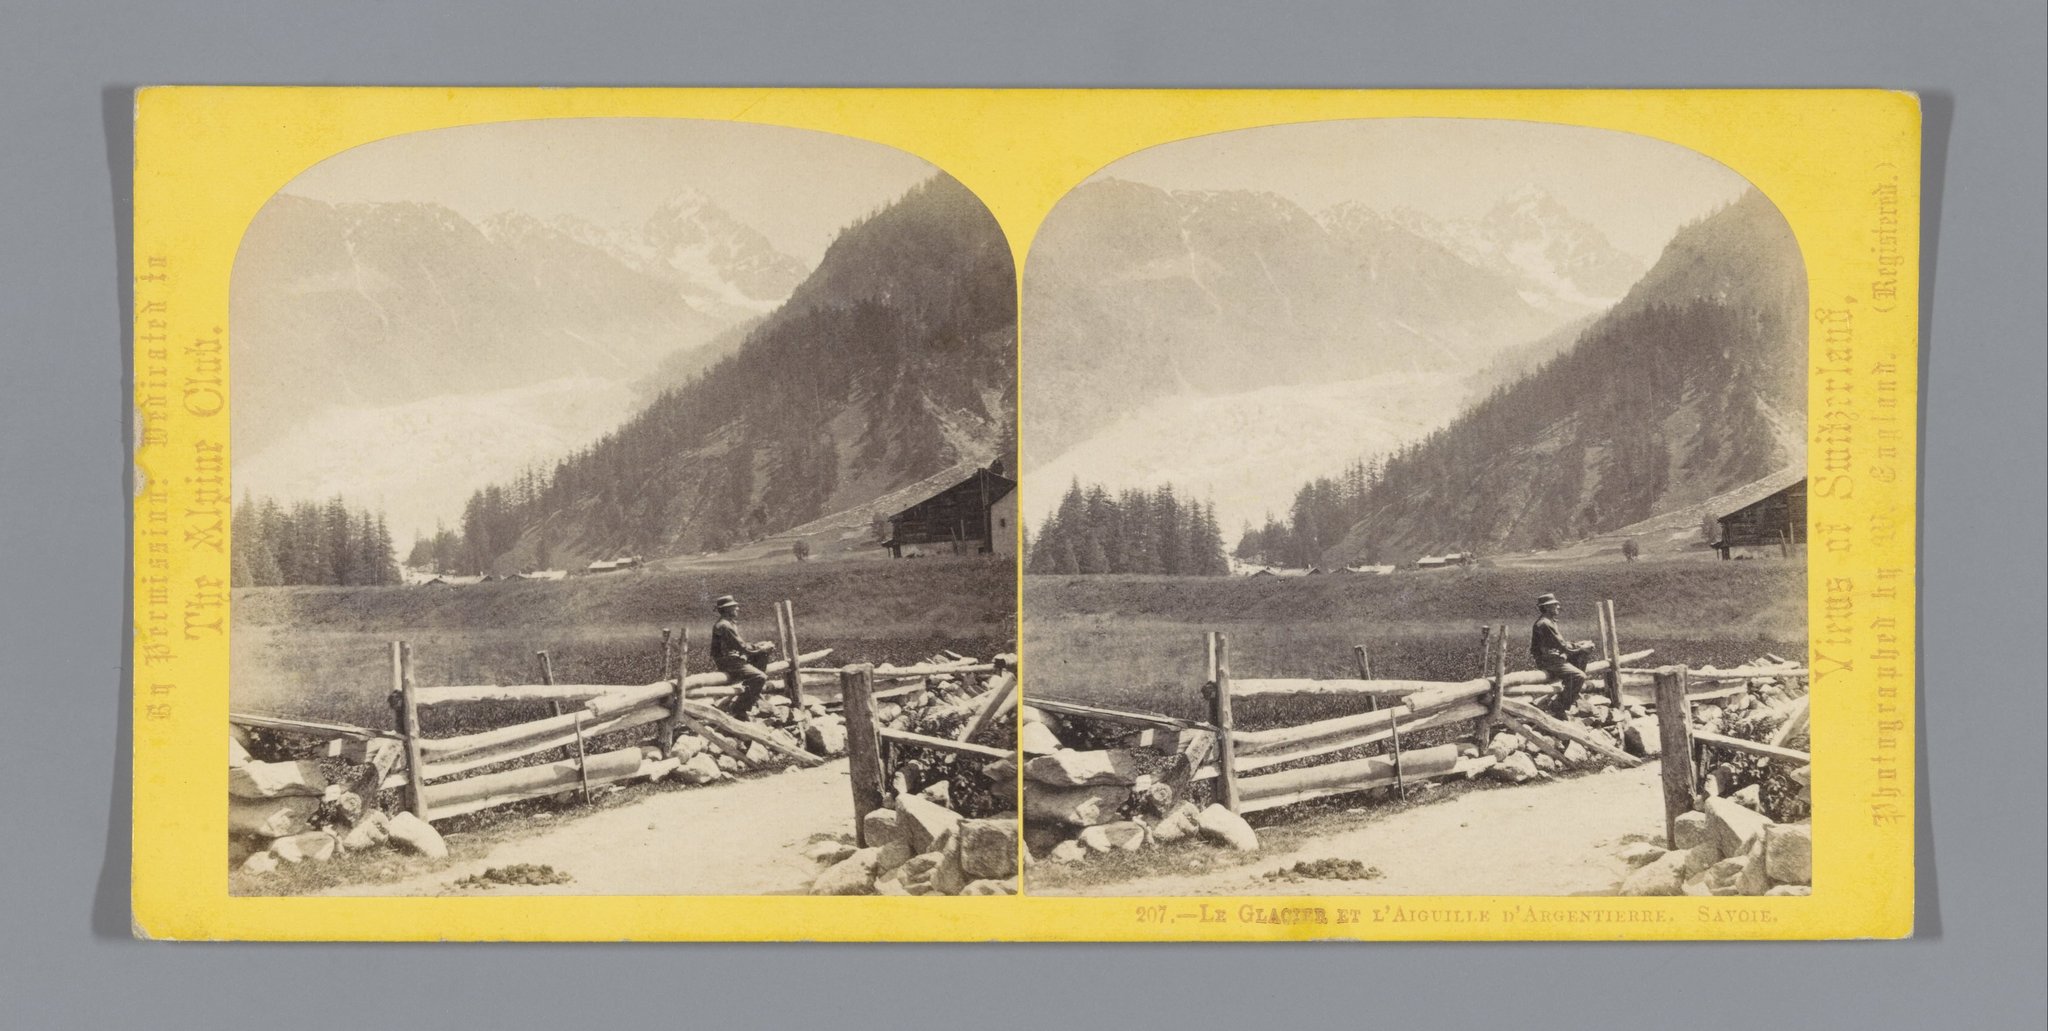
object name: stereograph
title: Gezicht op de Argentière-gletsjer en de Aiguille d'Argentière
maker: william england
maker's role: fotograaf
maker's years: 1816-1896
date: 1850-1880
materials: cardboard, photographic support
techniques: albumen print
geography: haute-savoie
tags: glacier, mountains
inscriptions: number: ‘207.’, inscription: ‘Views of Switzerland, photographed by W. England. (Registered) Under the Special Patronage of the Alpine Club.’